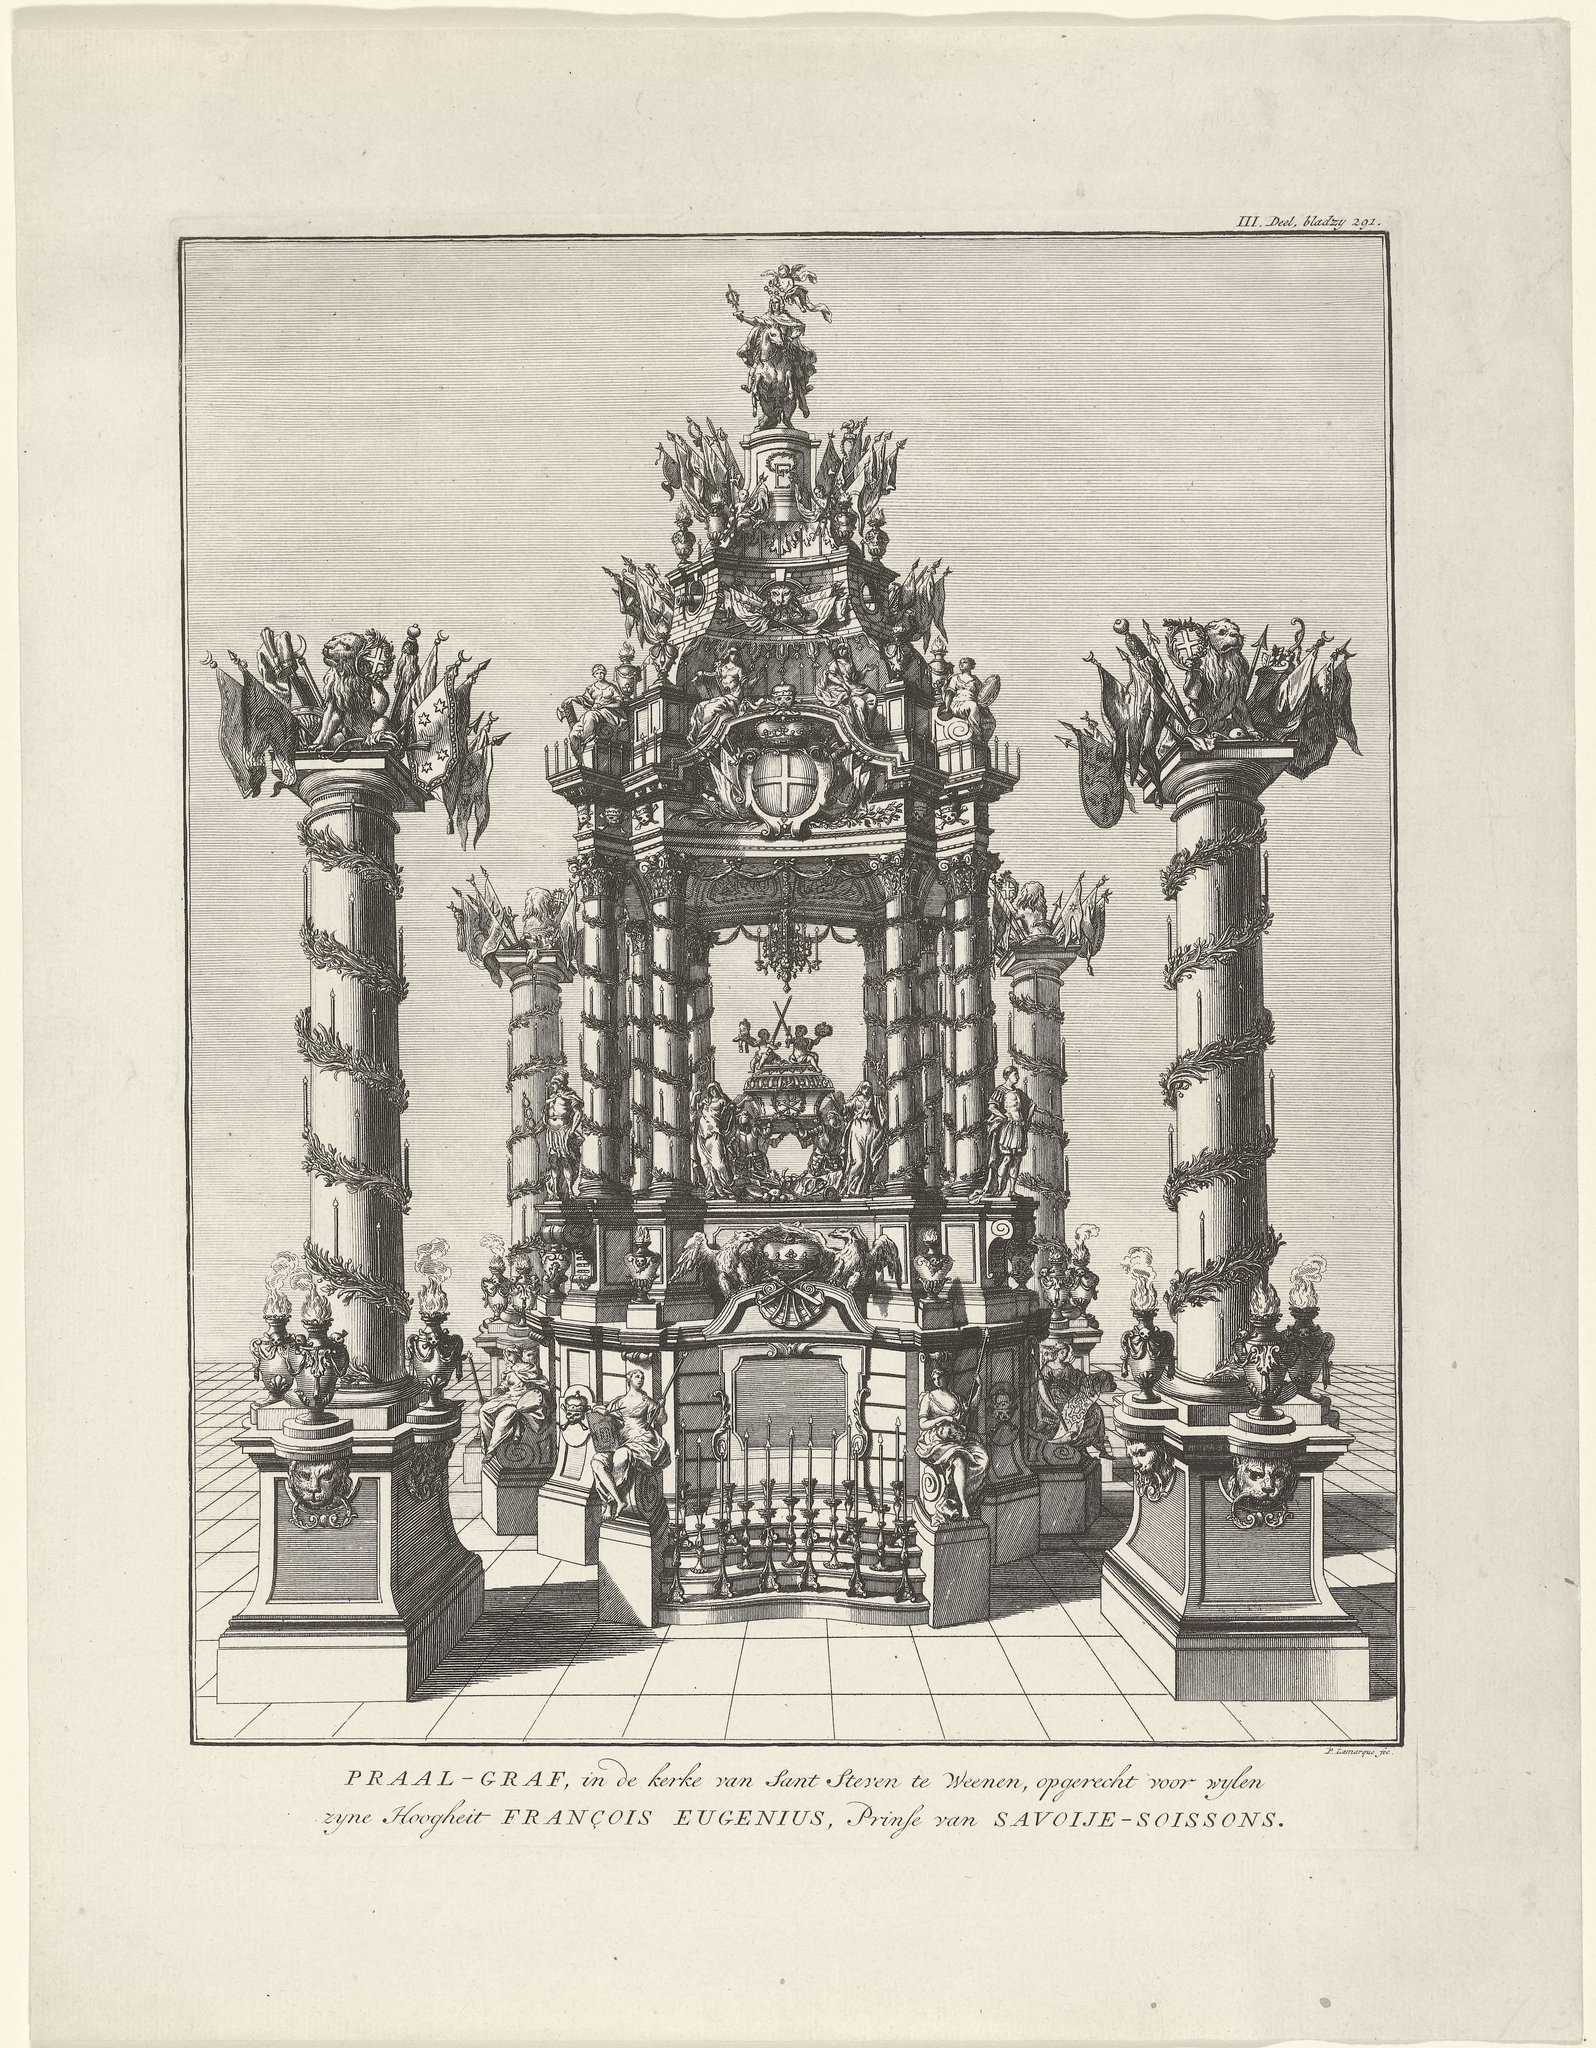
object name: print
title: Praalgraf van Eugène-François de Savoye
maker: pierre lamarque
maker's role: print maker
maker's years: 1716-1766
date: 1726-1766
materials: paper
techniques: engraving, etching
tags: paris, vienna, eugenius van savoye, grave-building, monumental tomb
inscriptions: collector's mark: Lugt 2228, collector's mark: Lugt 2760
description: Het praalgraf van Eugène-François, prins van Savoye, in de Stephansdom te Wenen. Prent rechtsboven gemerkt: III. Deel, bladzy 291.